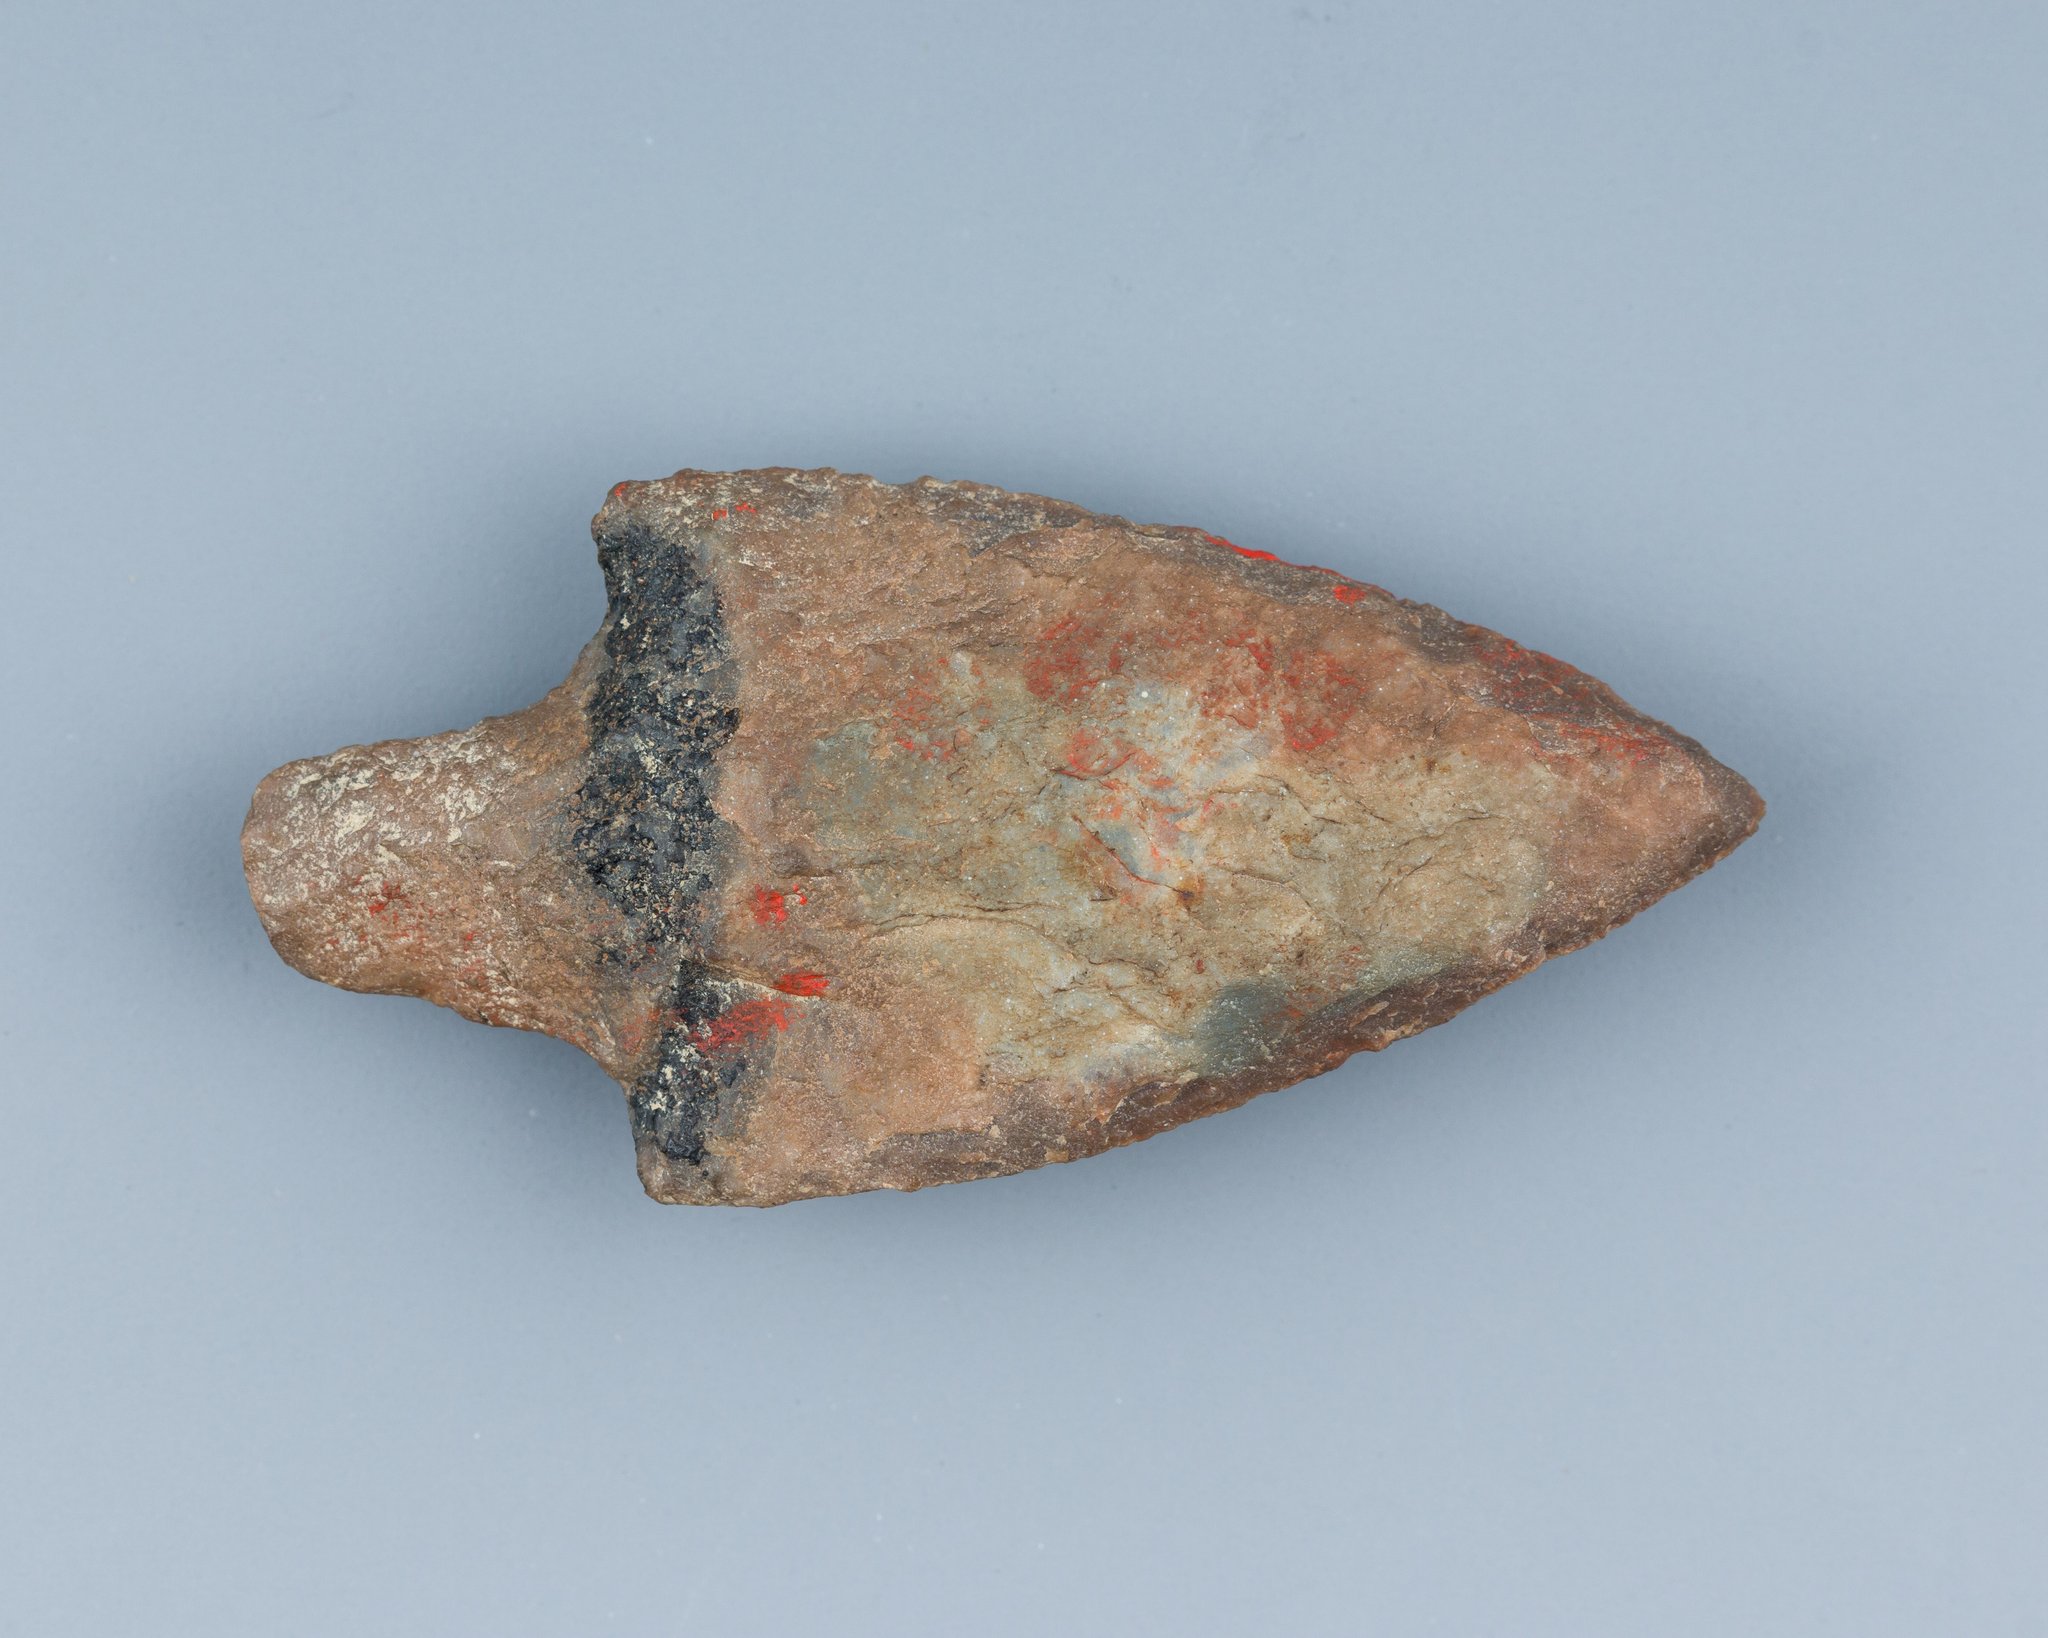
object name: arrowhead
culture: italian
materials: stone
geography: italy